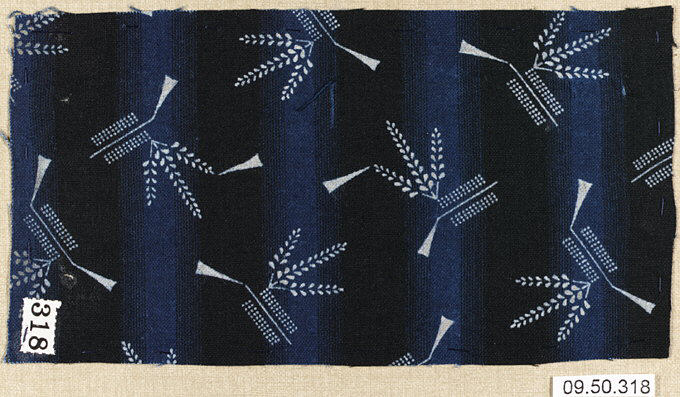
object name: piece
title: Piece (one of 116)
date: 1801-1900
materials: cotton